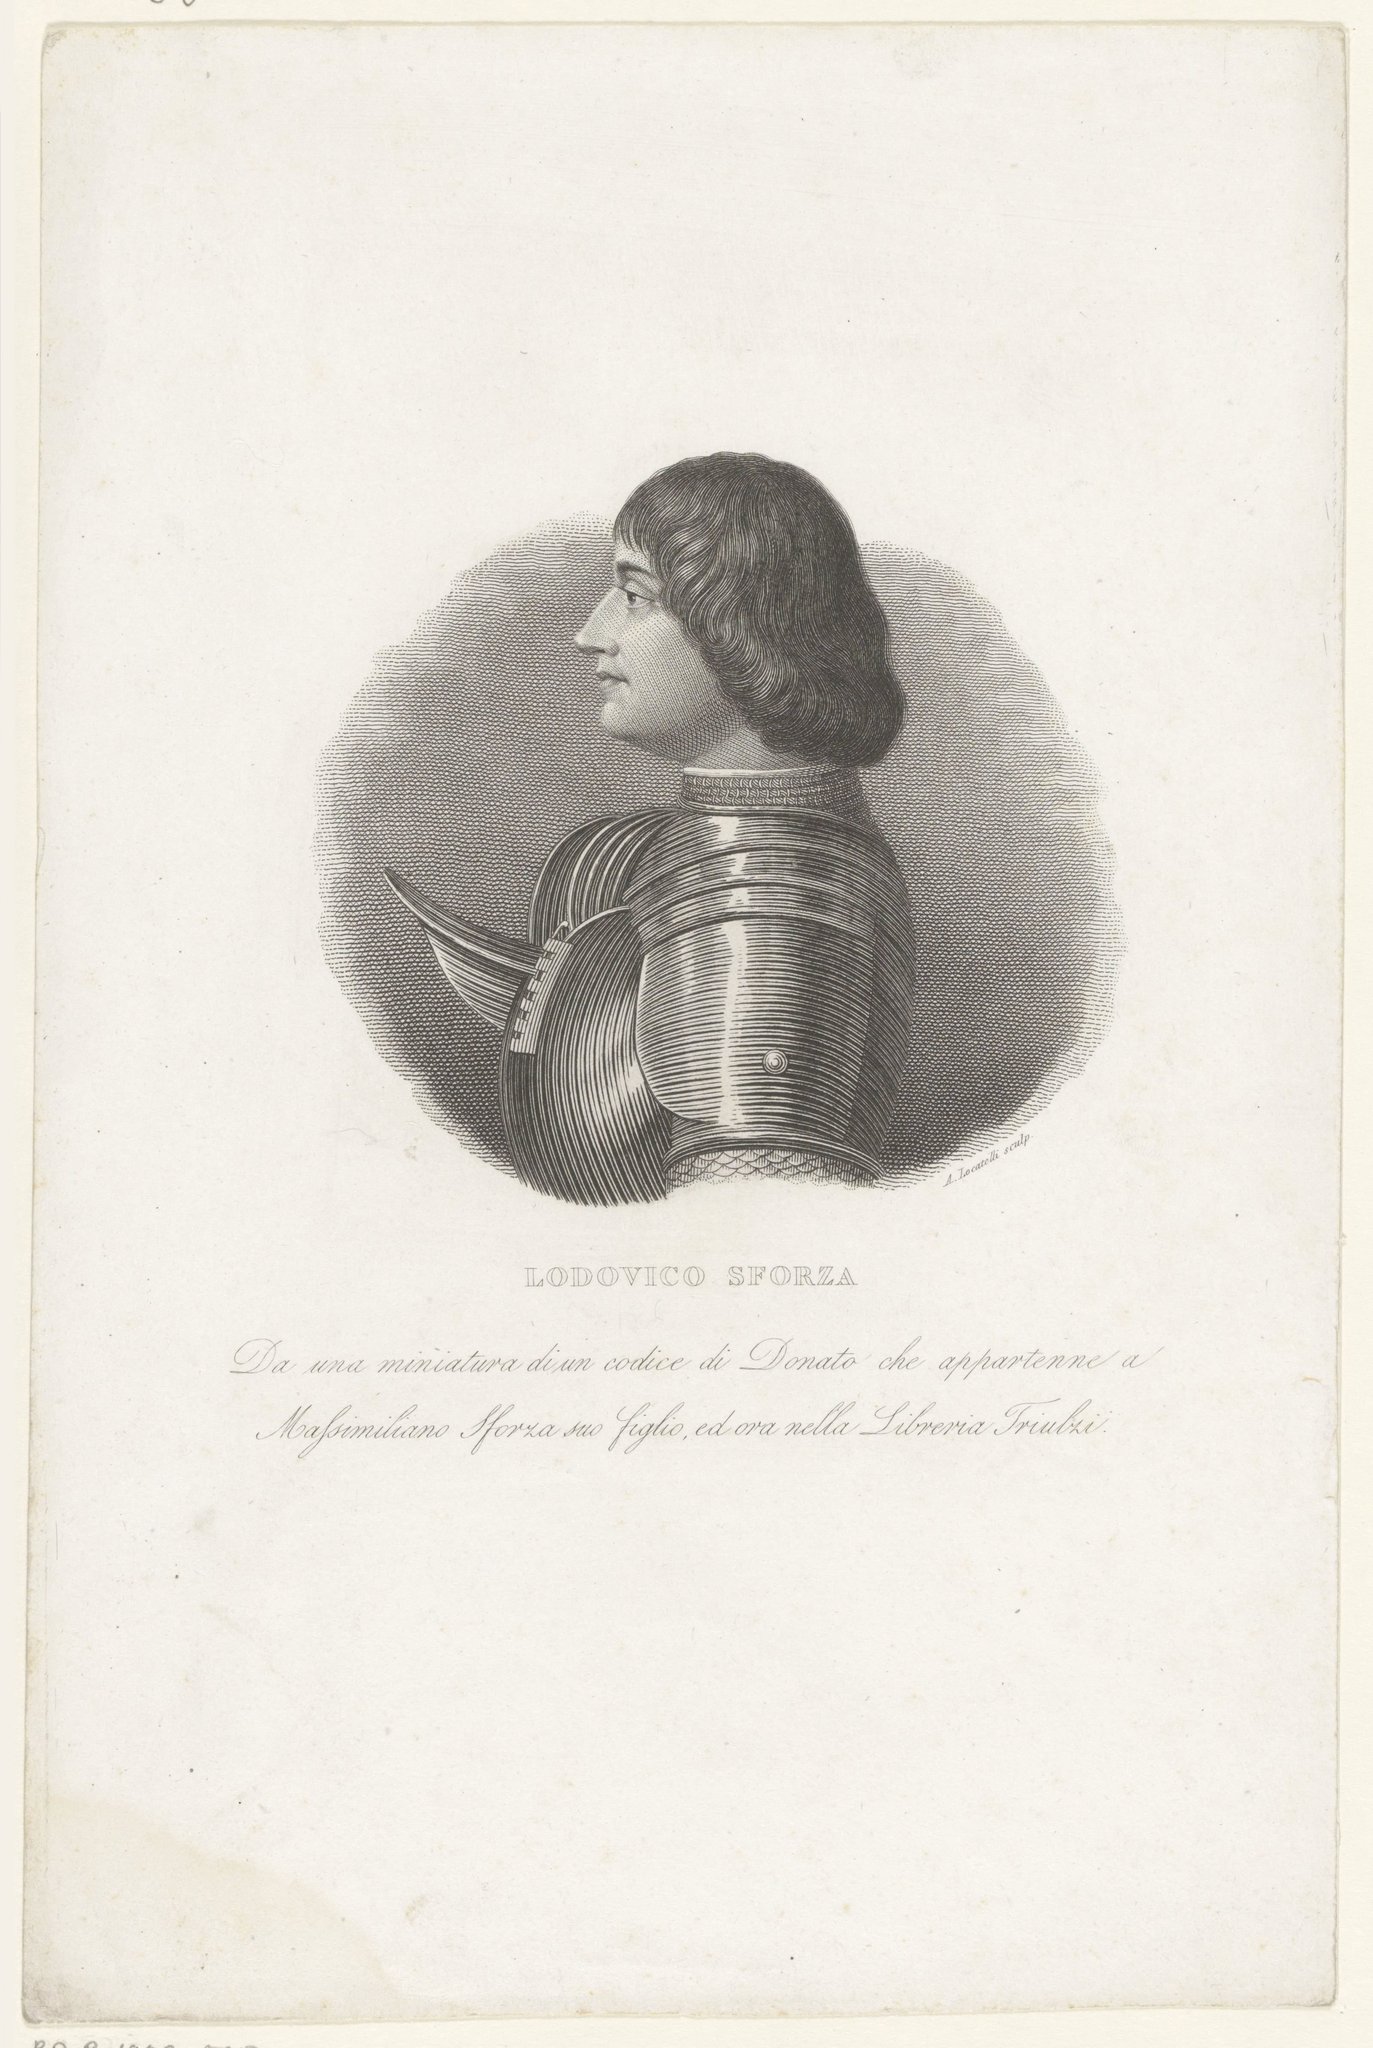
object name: print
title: Portret van Ludovico Sforza, hertog van Milaan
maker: antonio locatelli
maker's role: print maker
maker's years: 1800-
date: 1800-1899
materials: paper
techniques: engraving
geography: italy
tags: politician, historical persons, ruler, sovereign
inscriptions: collector's mark: Lugt 2228